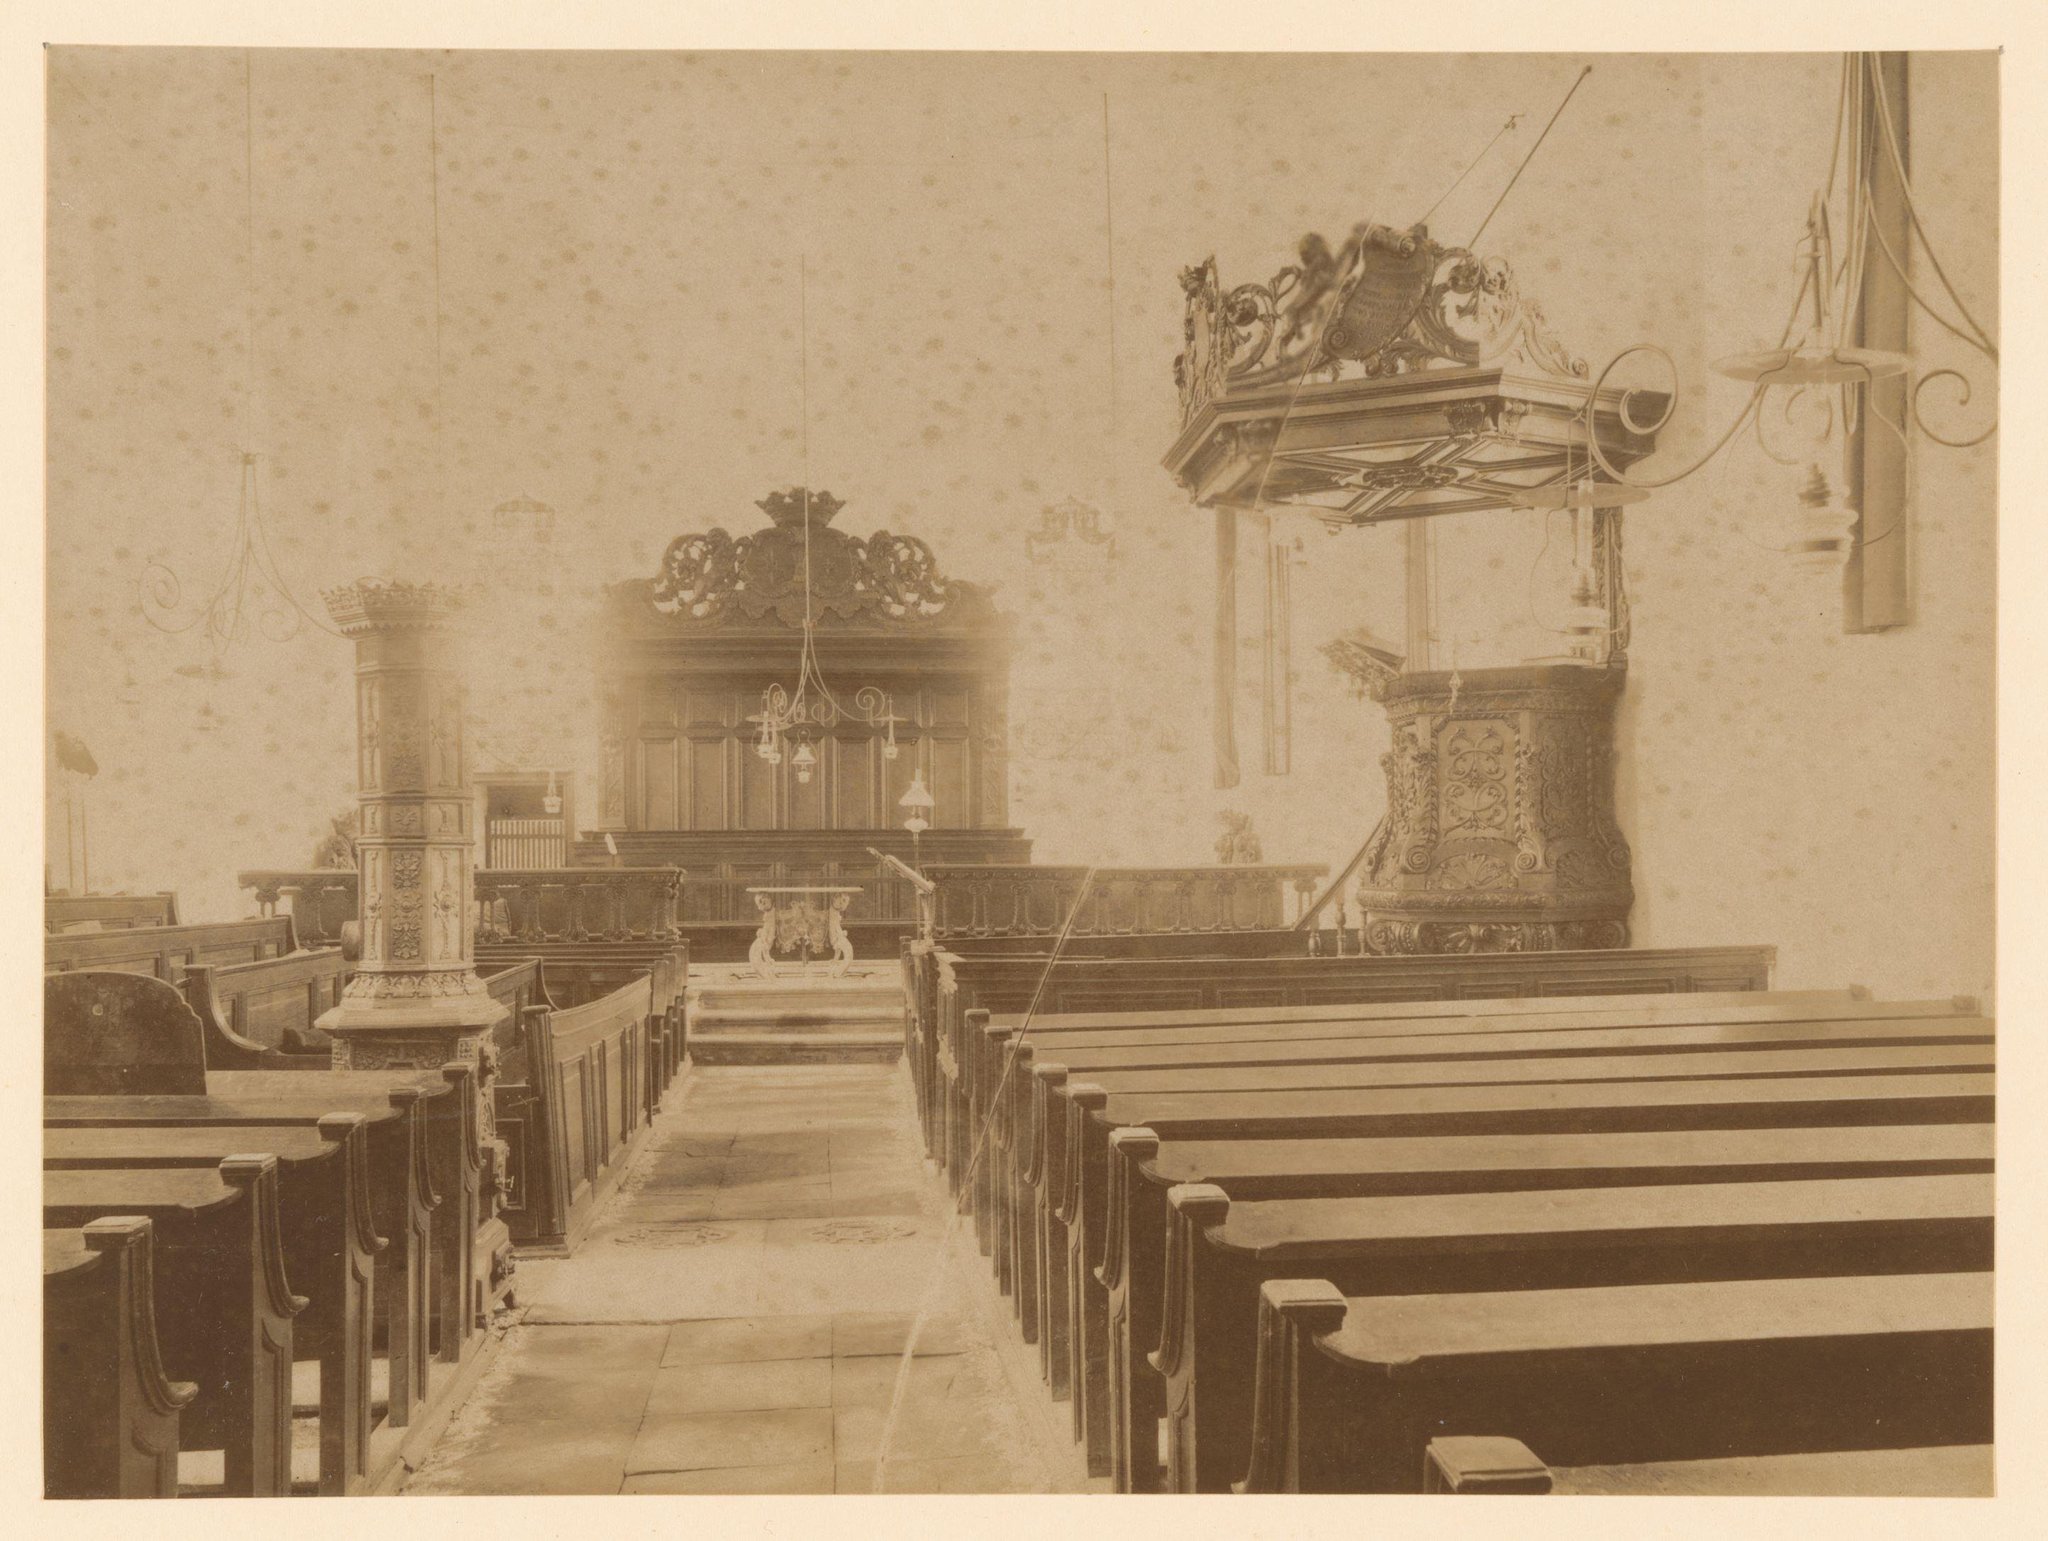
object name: photograph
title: Interieur van de abdijkerk te Aduard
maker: anoniem (monumentenzorg)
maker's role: fotograaf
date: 1900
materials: cardboard, photographic support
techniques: albumen print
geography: aduard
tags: parts of church interior: niche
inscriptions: annotation: ‘Het inwendigen der N.H. kerk te Aduard (Gr.)/ juni 1900’, annotation: ‘Aduard’